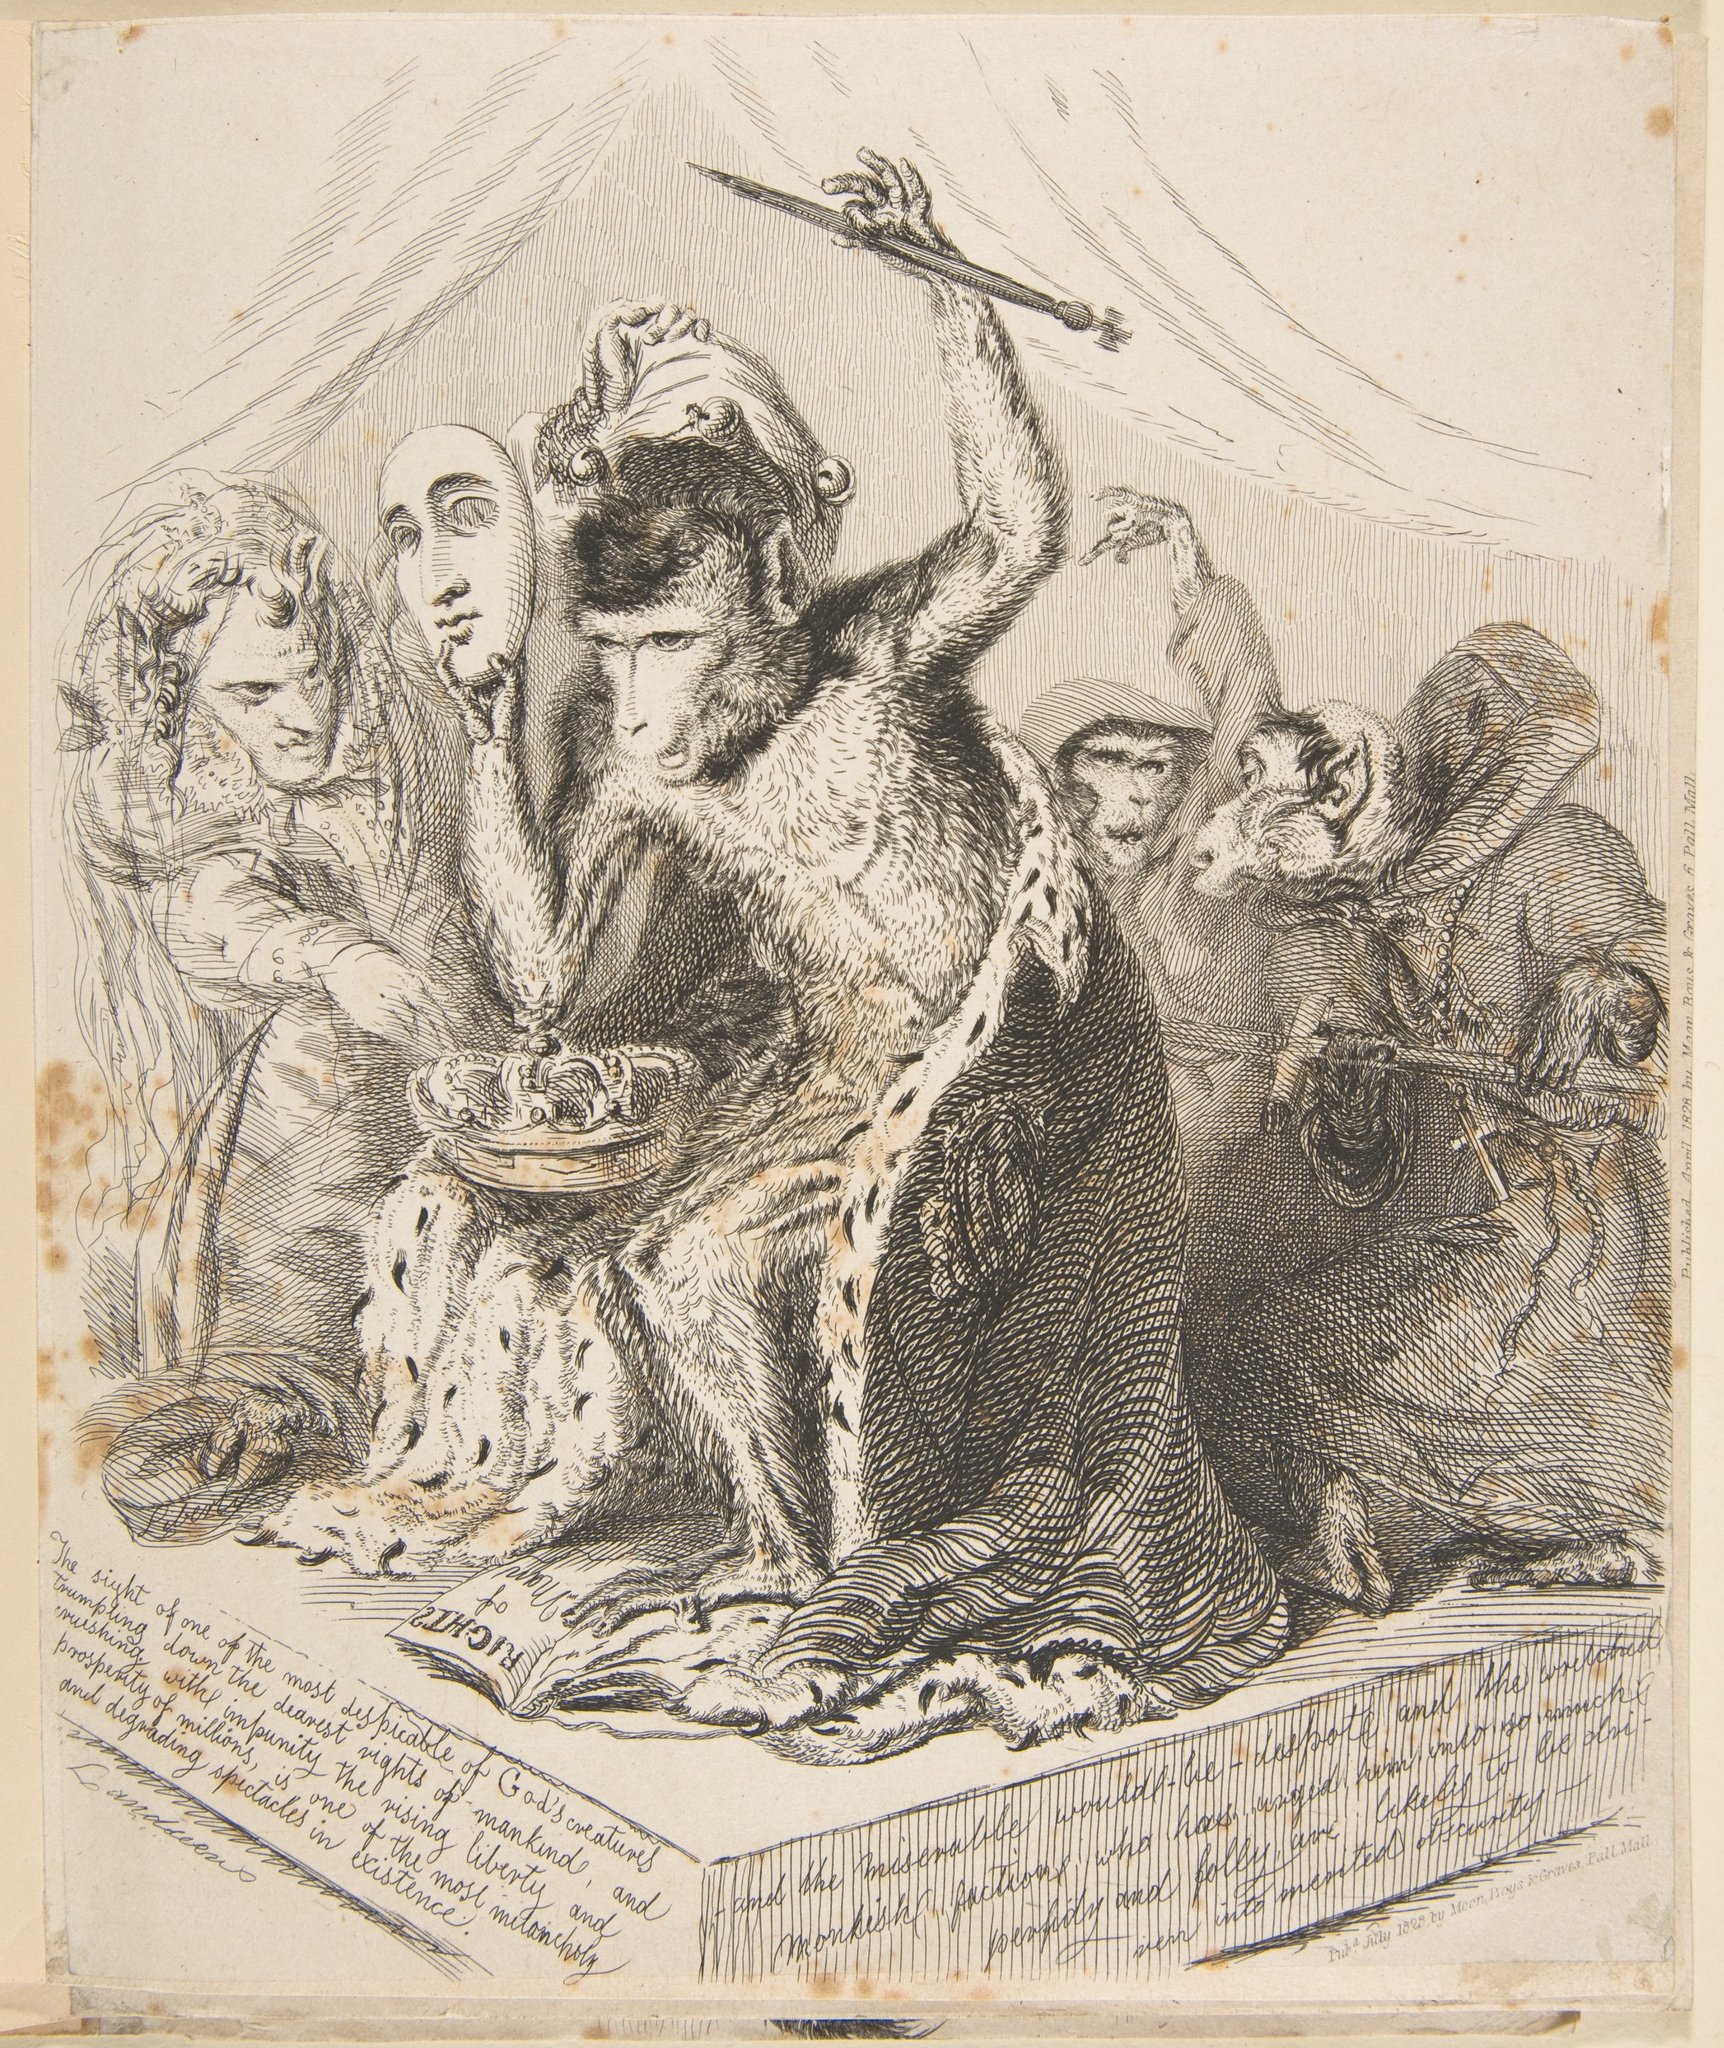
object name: print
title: Monkey Despot, from Monkey-Ana or Men, in Miniature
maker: thomas landseer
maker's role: artist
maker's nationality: british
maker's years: 1795-1880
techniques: etching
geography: france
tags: masks,men,monkeys